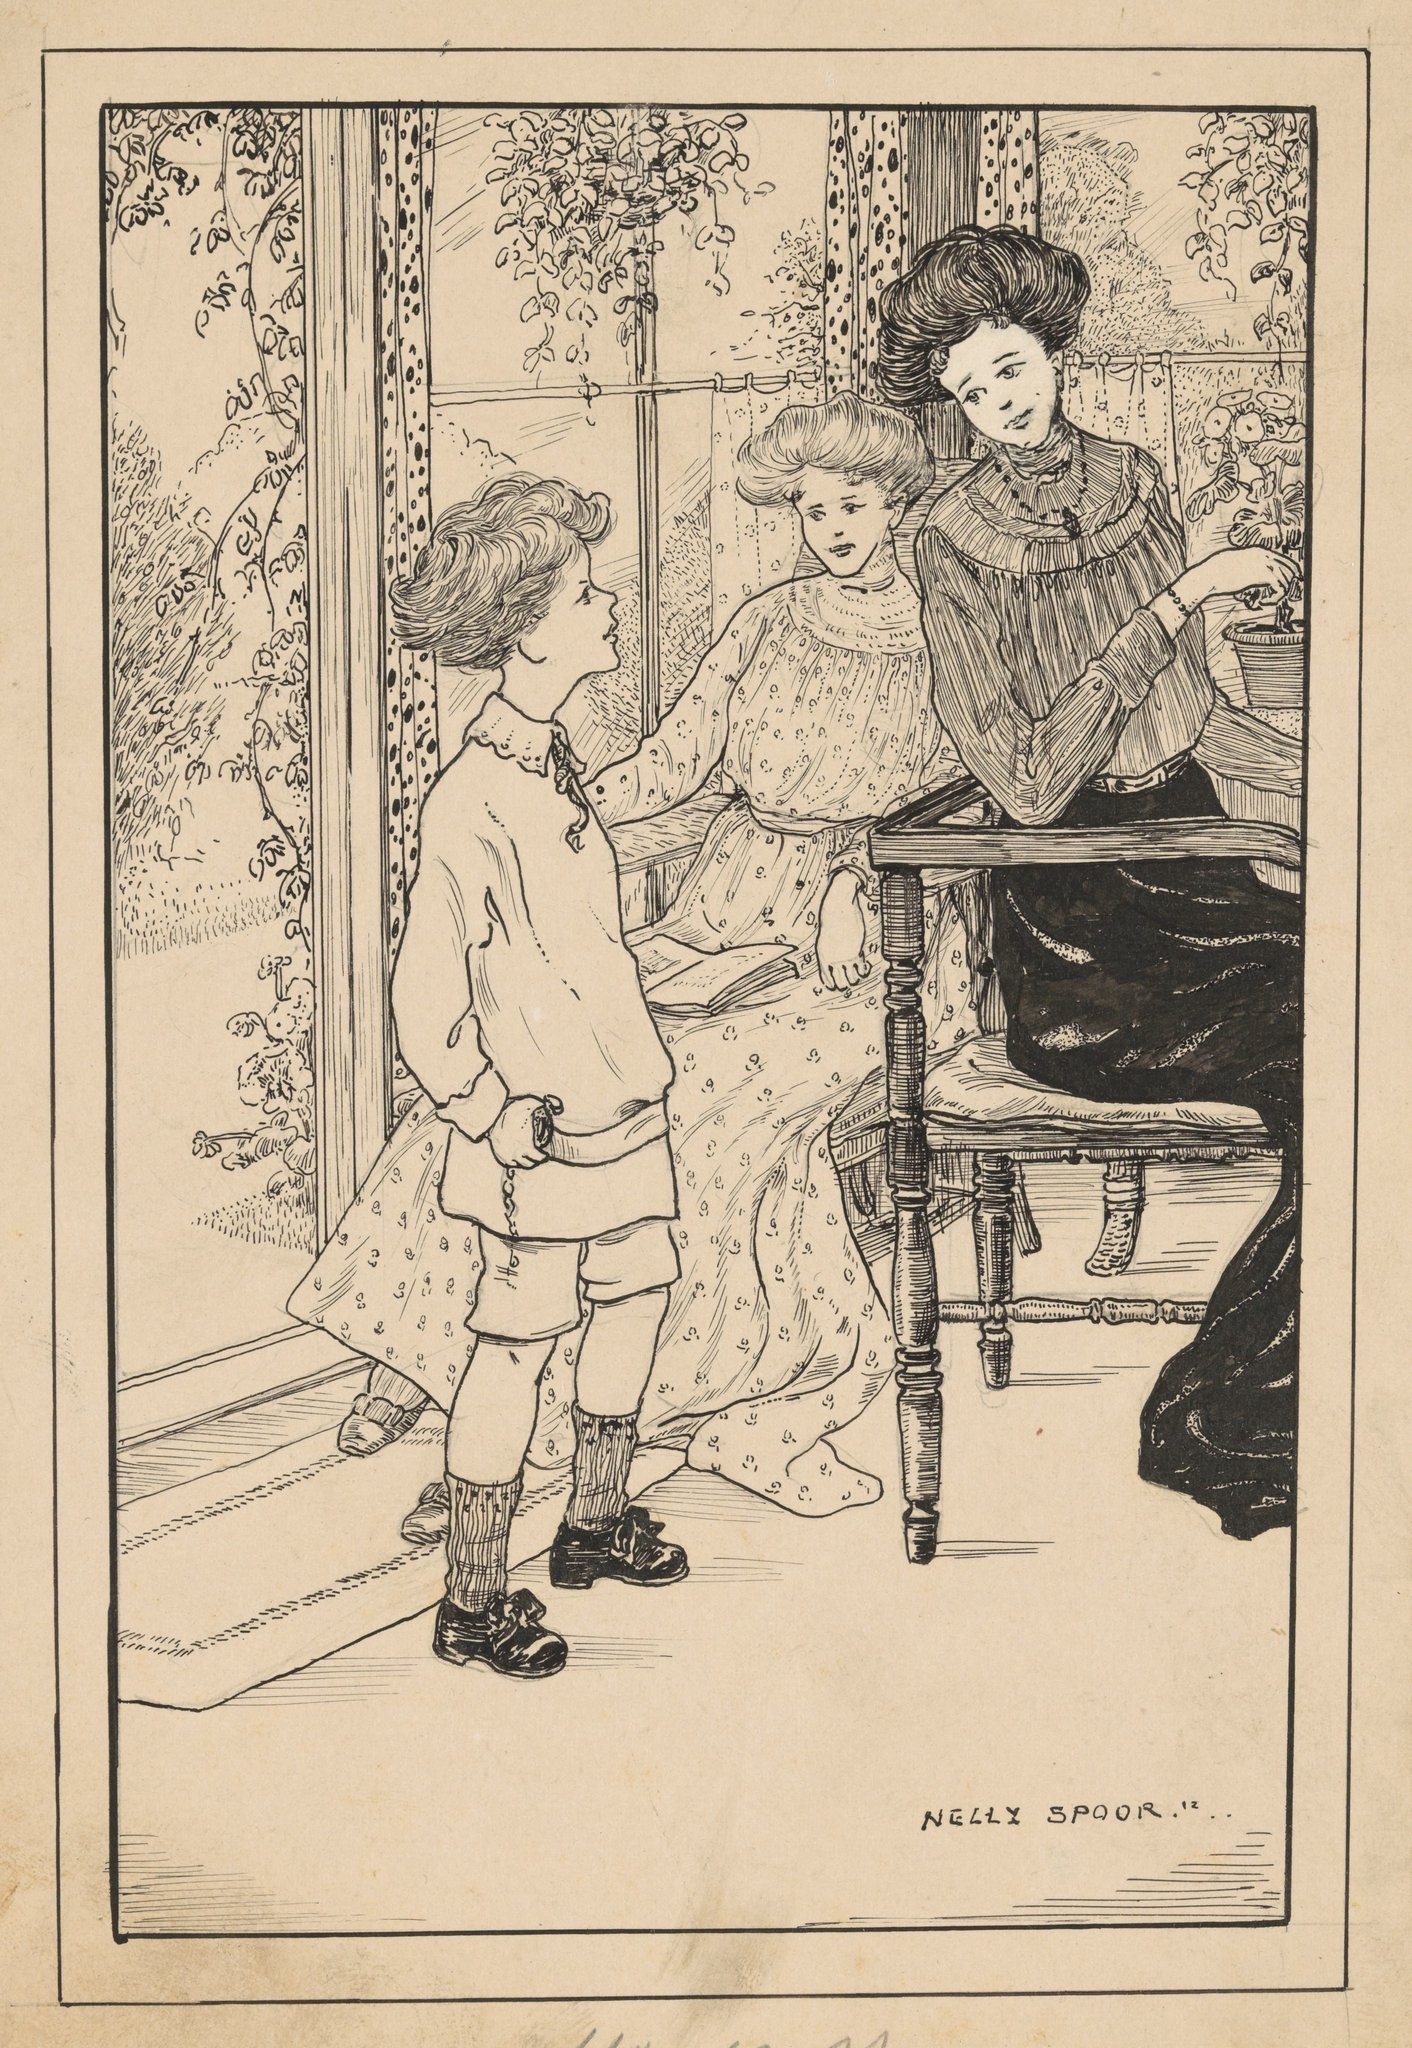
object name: drawing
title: Twee vrouwen en een jongen in een serre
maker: nelly spoor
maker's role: draughtsman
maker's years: 1885-1950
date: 1912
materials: cardboard, ink, paper, pencil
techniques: pen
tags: sitting figure - aa - female human figure, sun-porch, sun-parlour, glazed verandah, boy (child between toddler and youth)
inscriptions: collector's mark: Lugt 2228, :, signature and date: ‘NELLY SPOOR. 12’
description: In een serre zit een vrouw aan een tafel. Een tweede vrouw zit met een boek op schoot. De vrouwen kijken naar een jongen die door de open deur binnen is komen lopen. Hij heeft een buideltje in zijn hand.